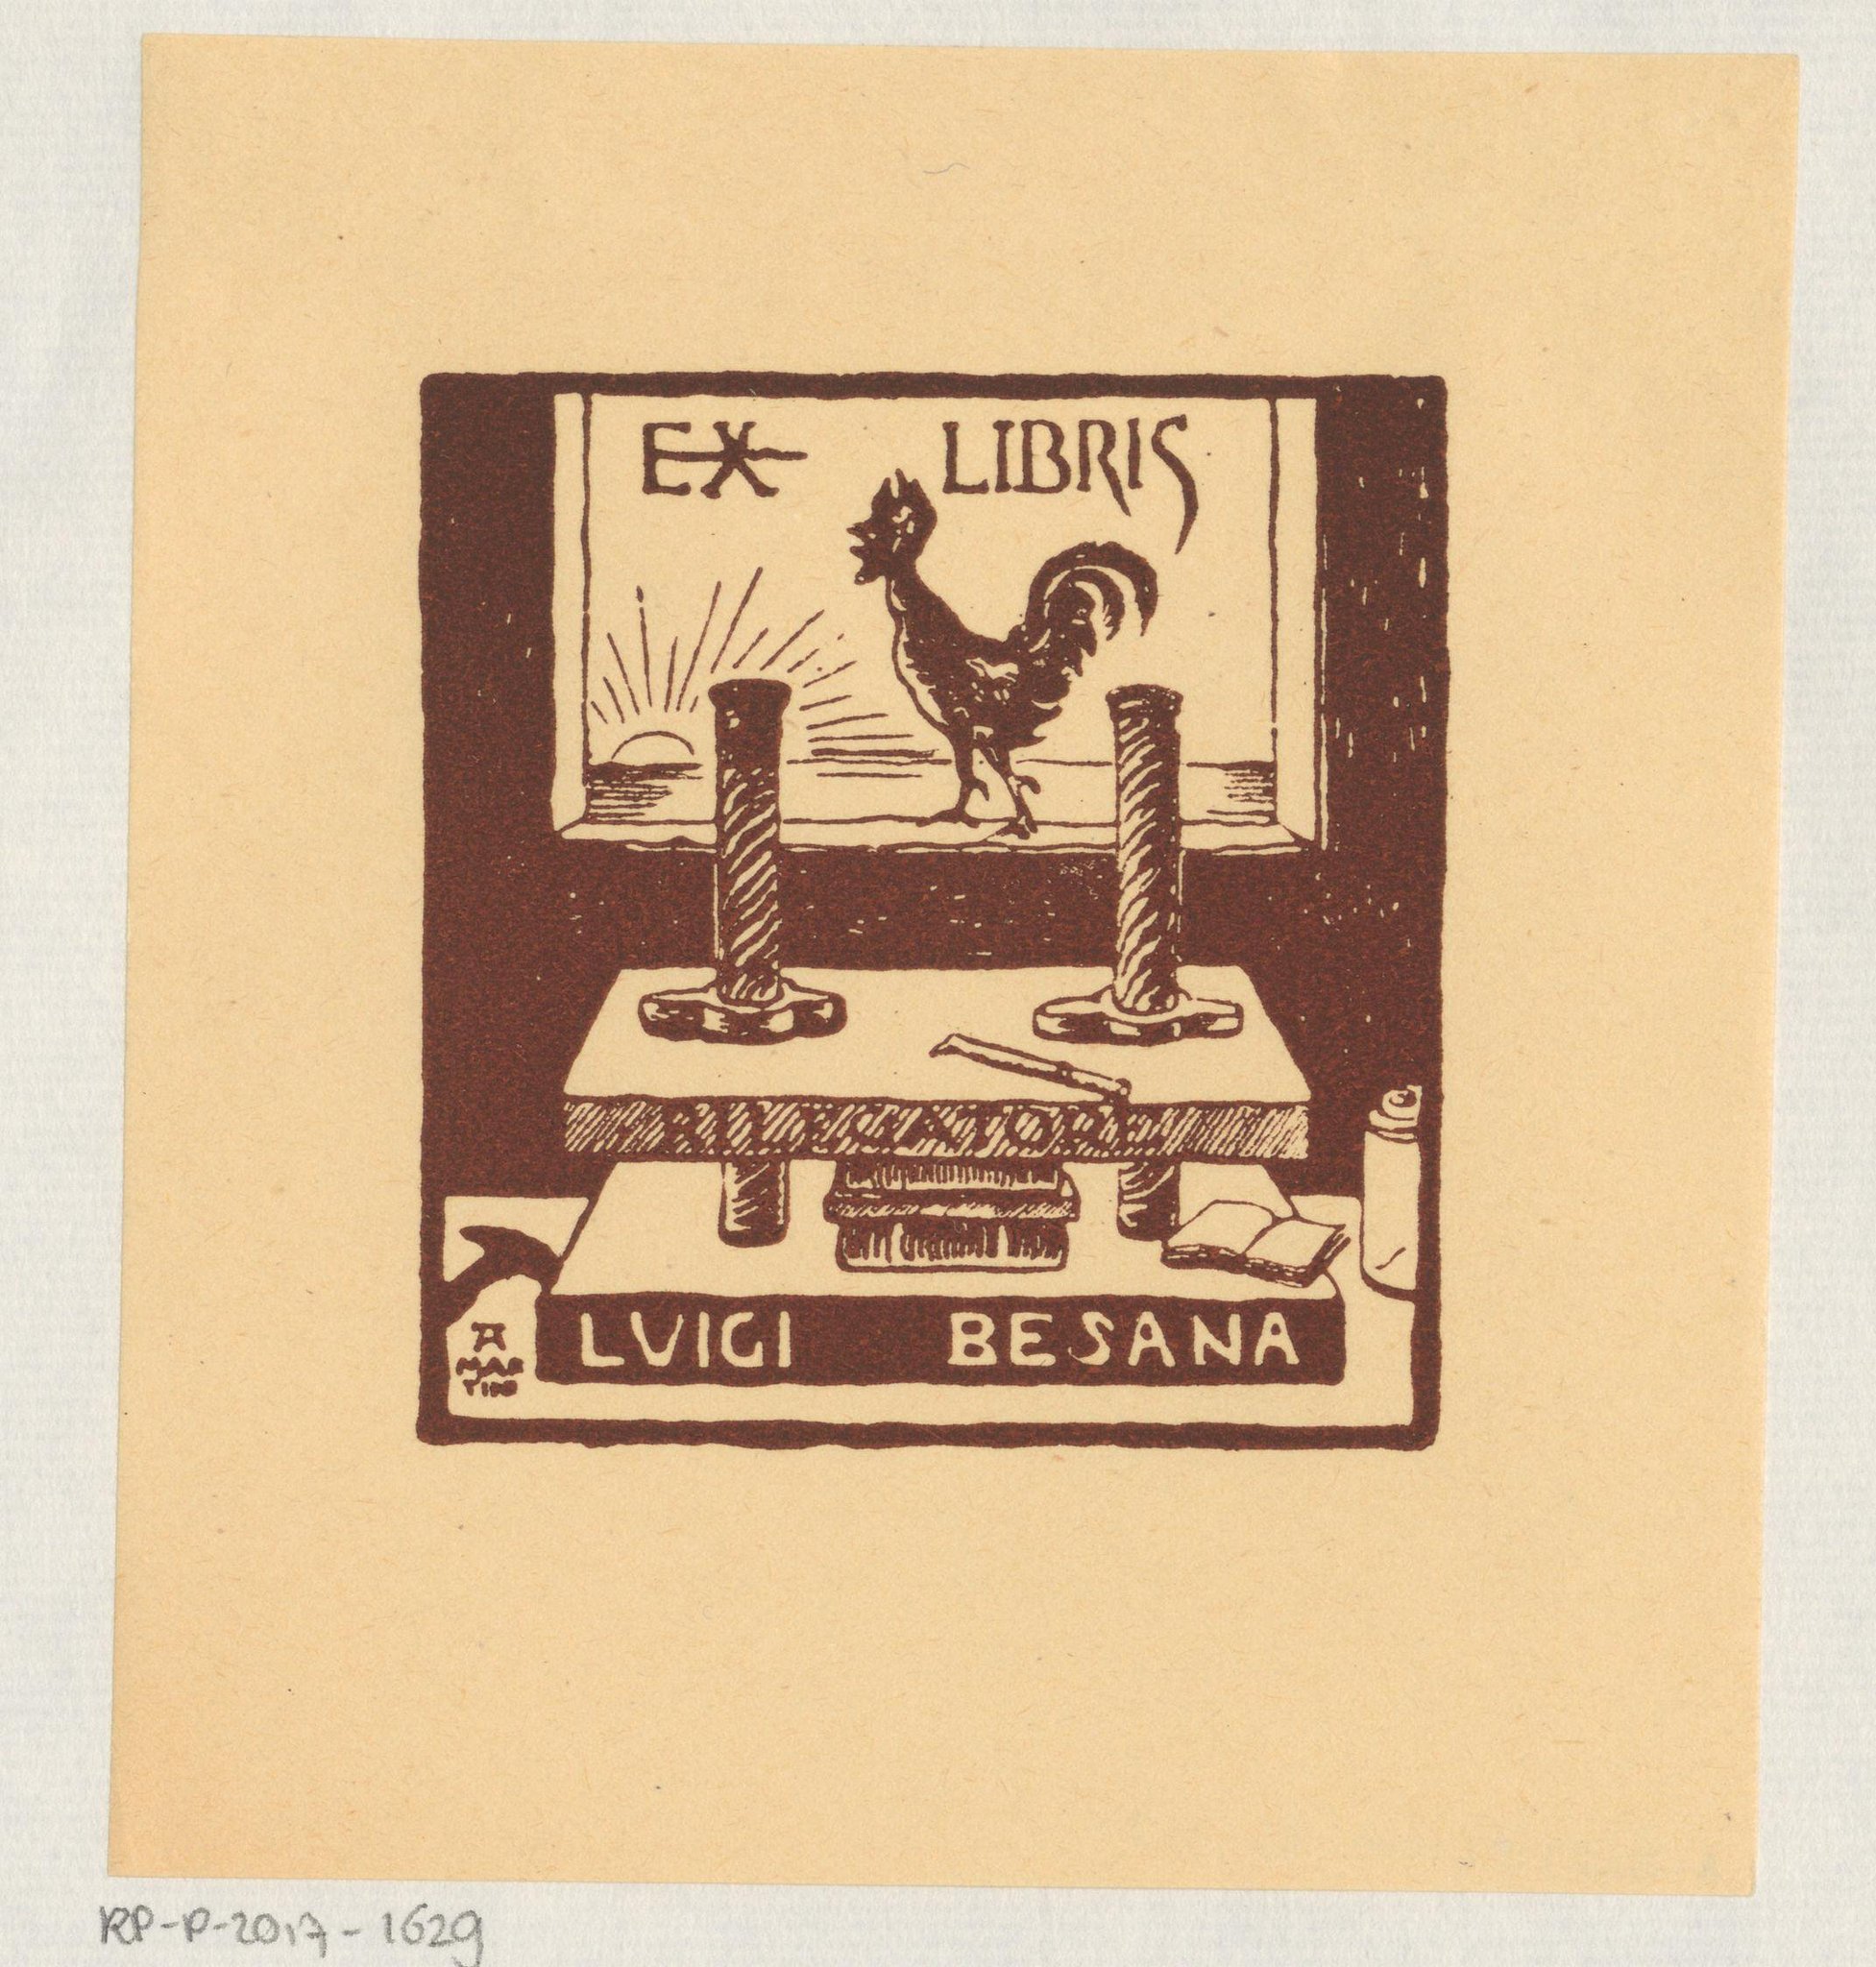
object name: bookplate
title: Ex libris van Luigi Besana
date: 1945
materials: paper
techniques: printing block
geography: italy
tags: bookbinding, book, sunrise, fowl (cock, hen, chicken, etc.)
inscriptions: workshop stamp: ‘A. Martini 1945. Cl.N. 2’